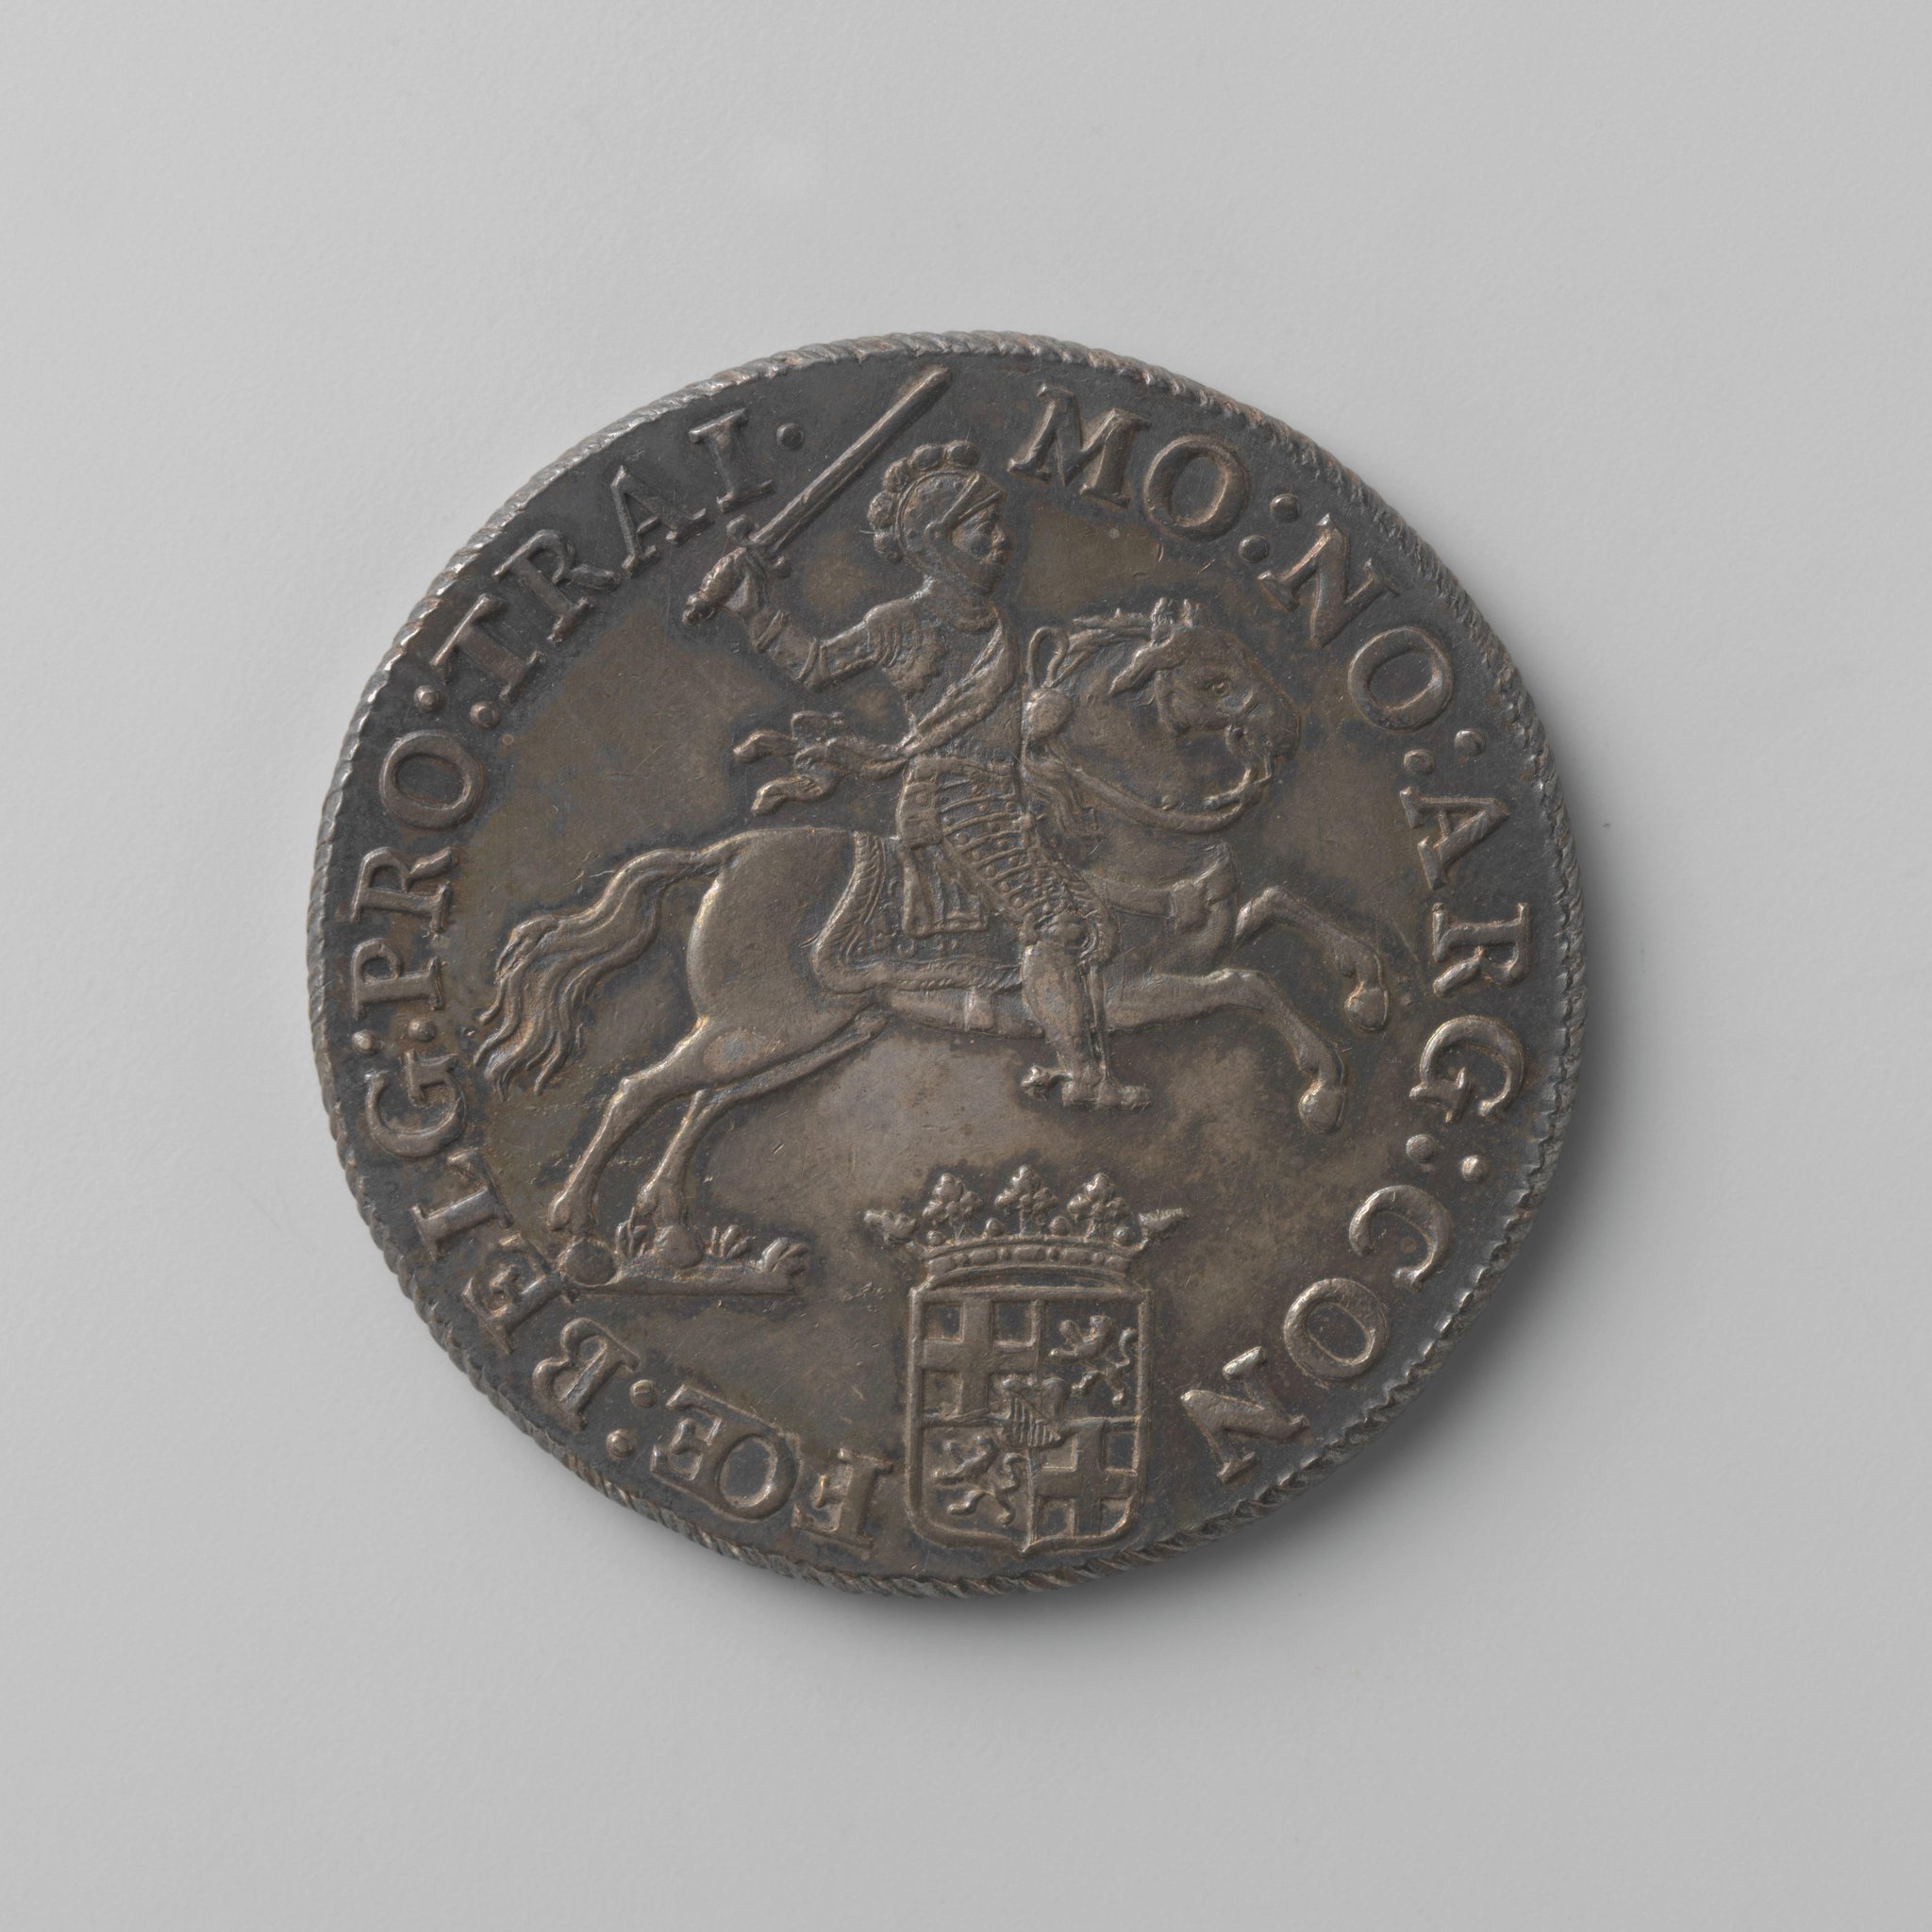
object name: coin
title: Utrecht, zilveren rijder, 1790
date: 1790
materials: silver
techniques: striking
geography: utrecht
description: Zilveren munt. Voorzijde: ridder te paard naar rechts met in rechterhand zwaard. Onder paard gekroond wapenschild van Utrecht. Keerzijde: door twee gekroonde leeuwen gehouden generaliteitswapenschild. Daaronder in cartouche jaartal. Kabelrand.